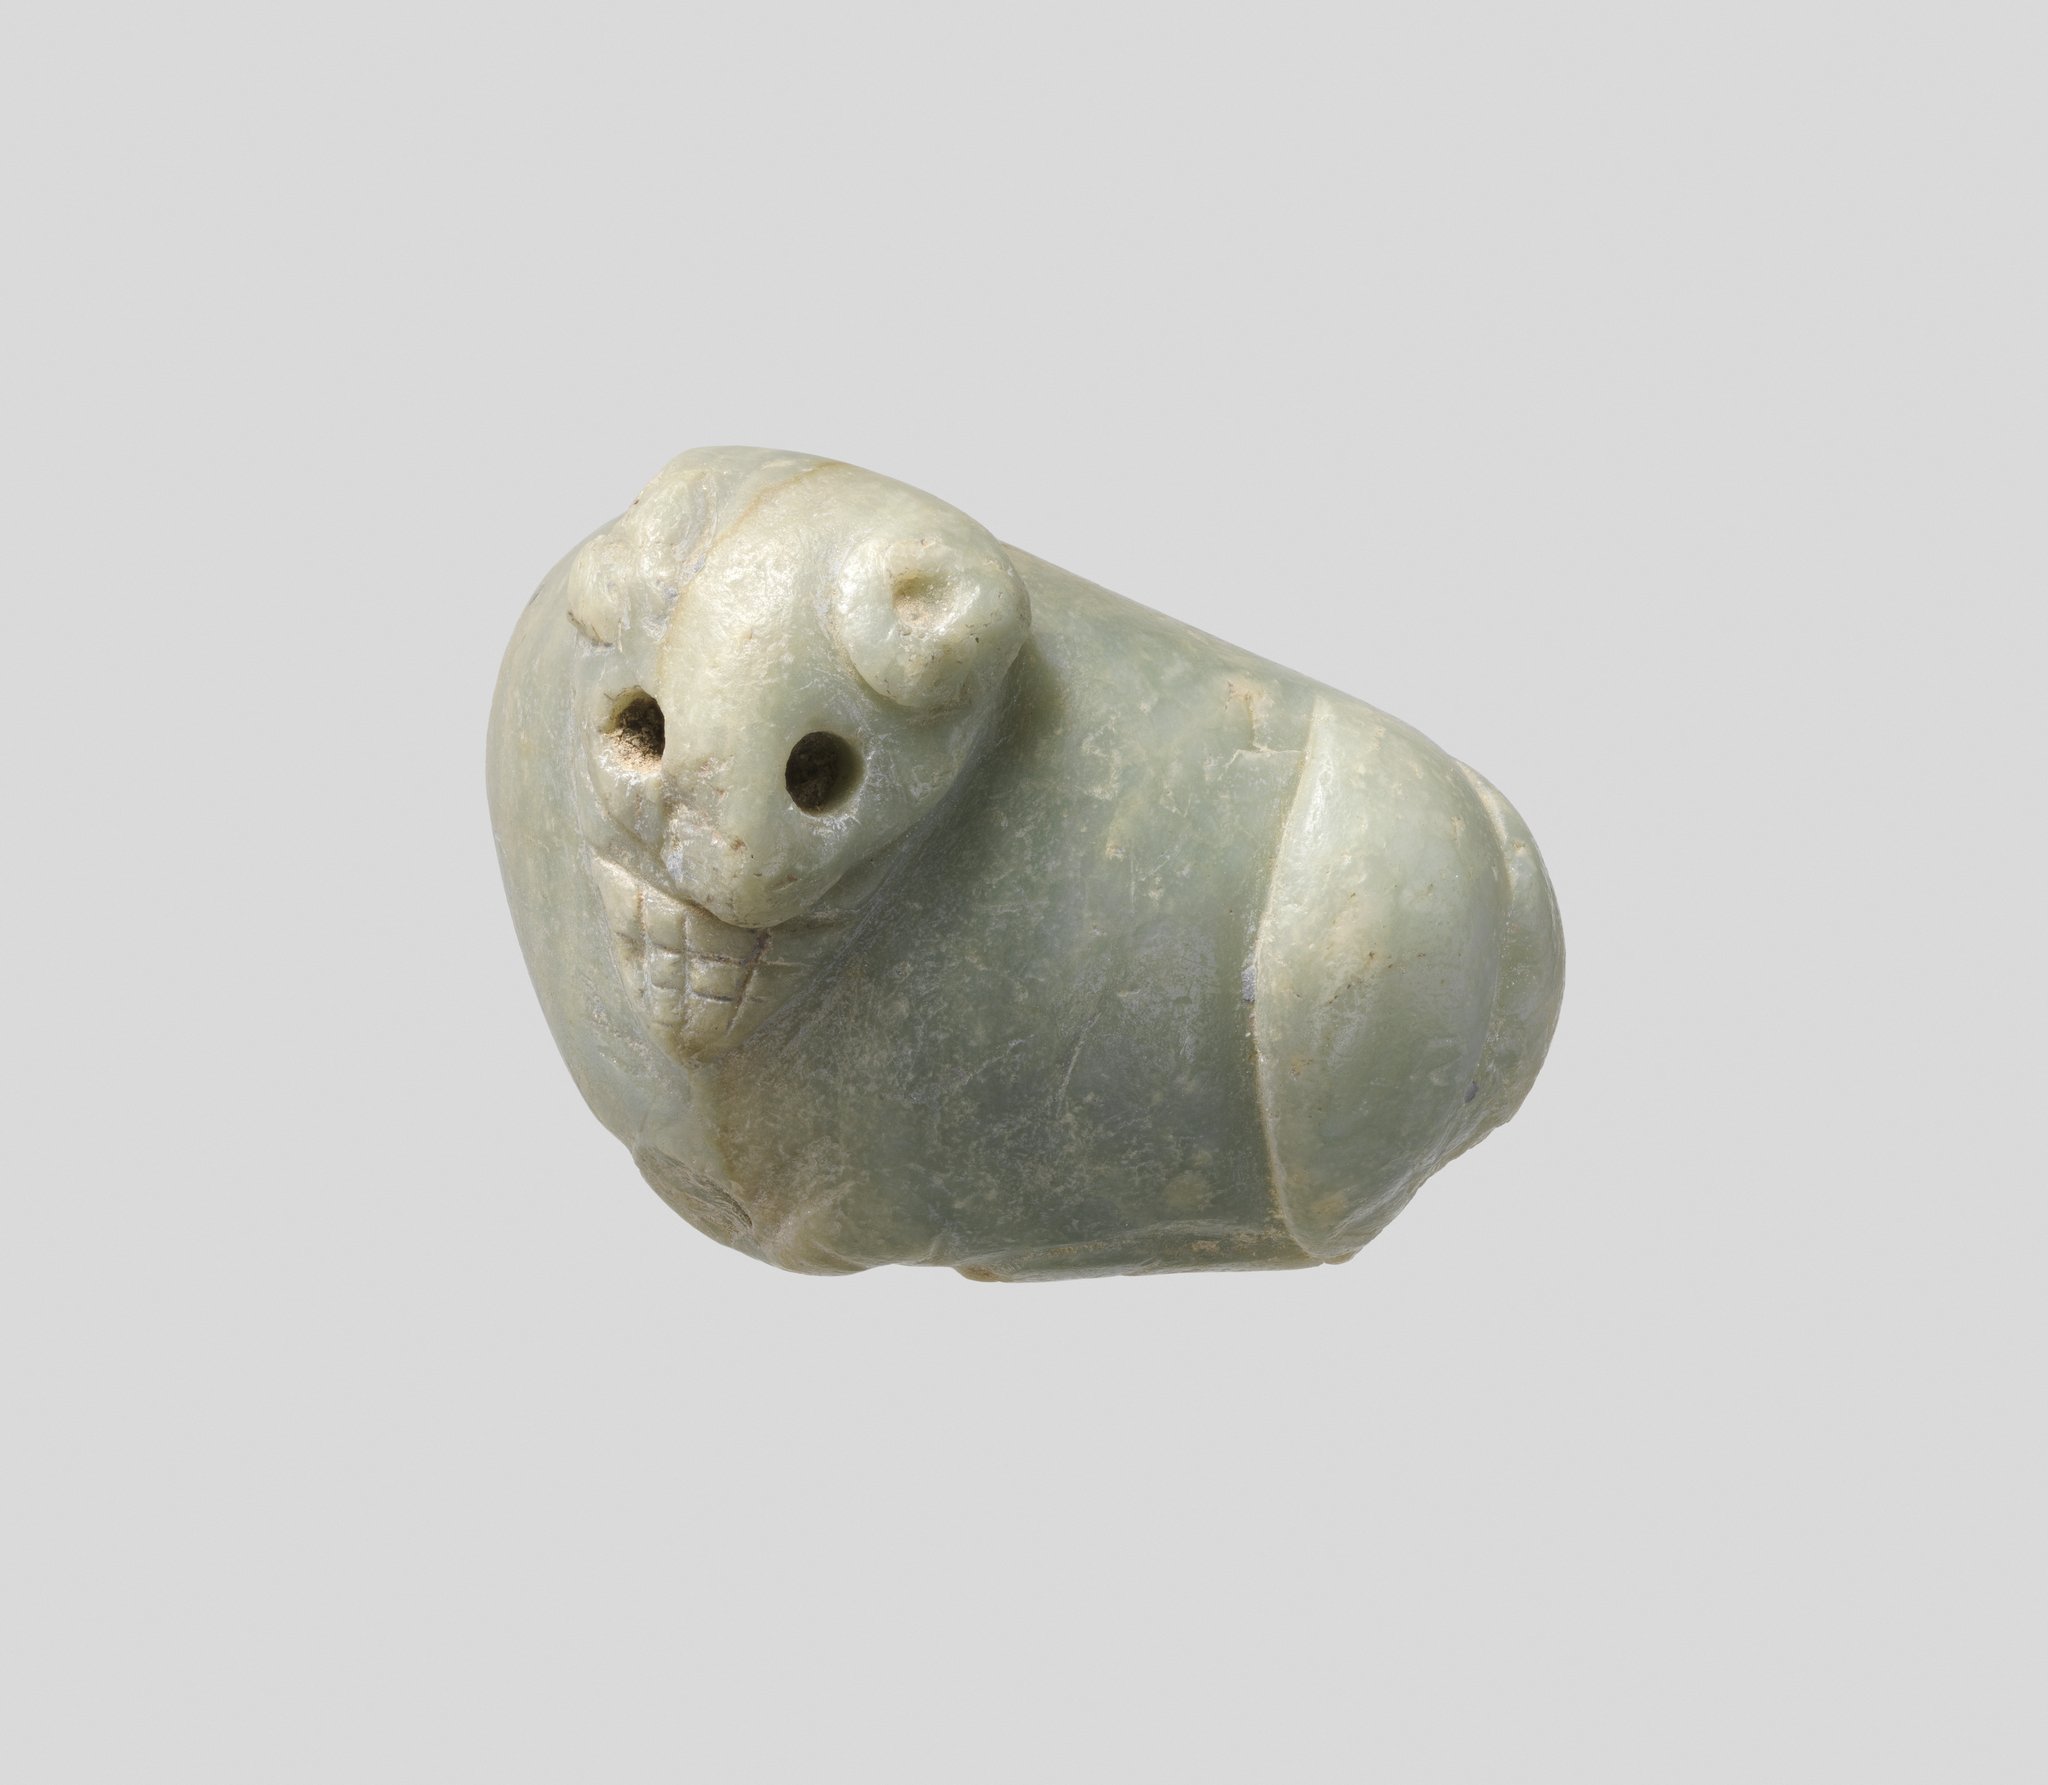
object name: stamp seal amulet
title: Seal amulet in the form of a reclining cow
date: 3300-2900 BCE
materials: alabaster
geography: southern mesopotamia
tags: cows